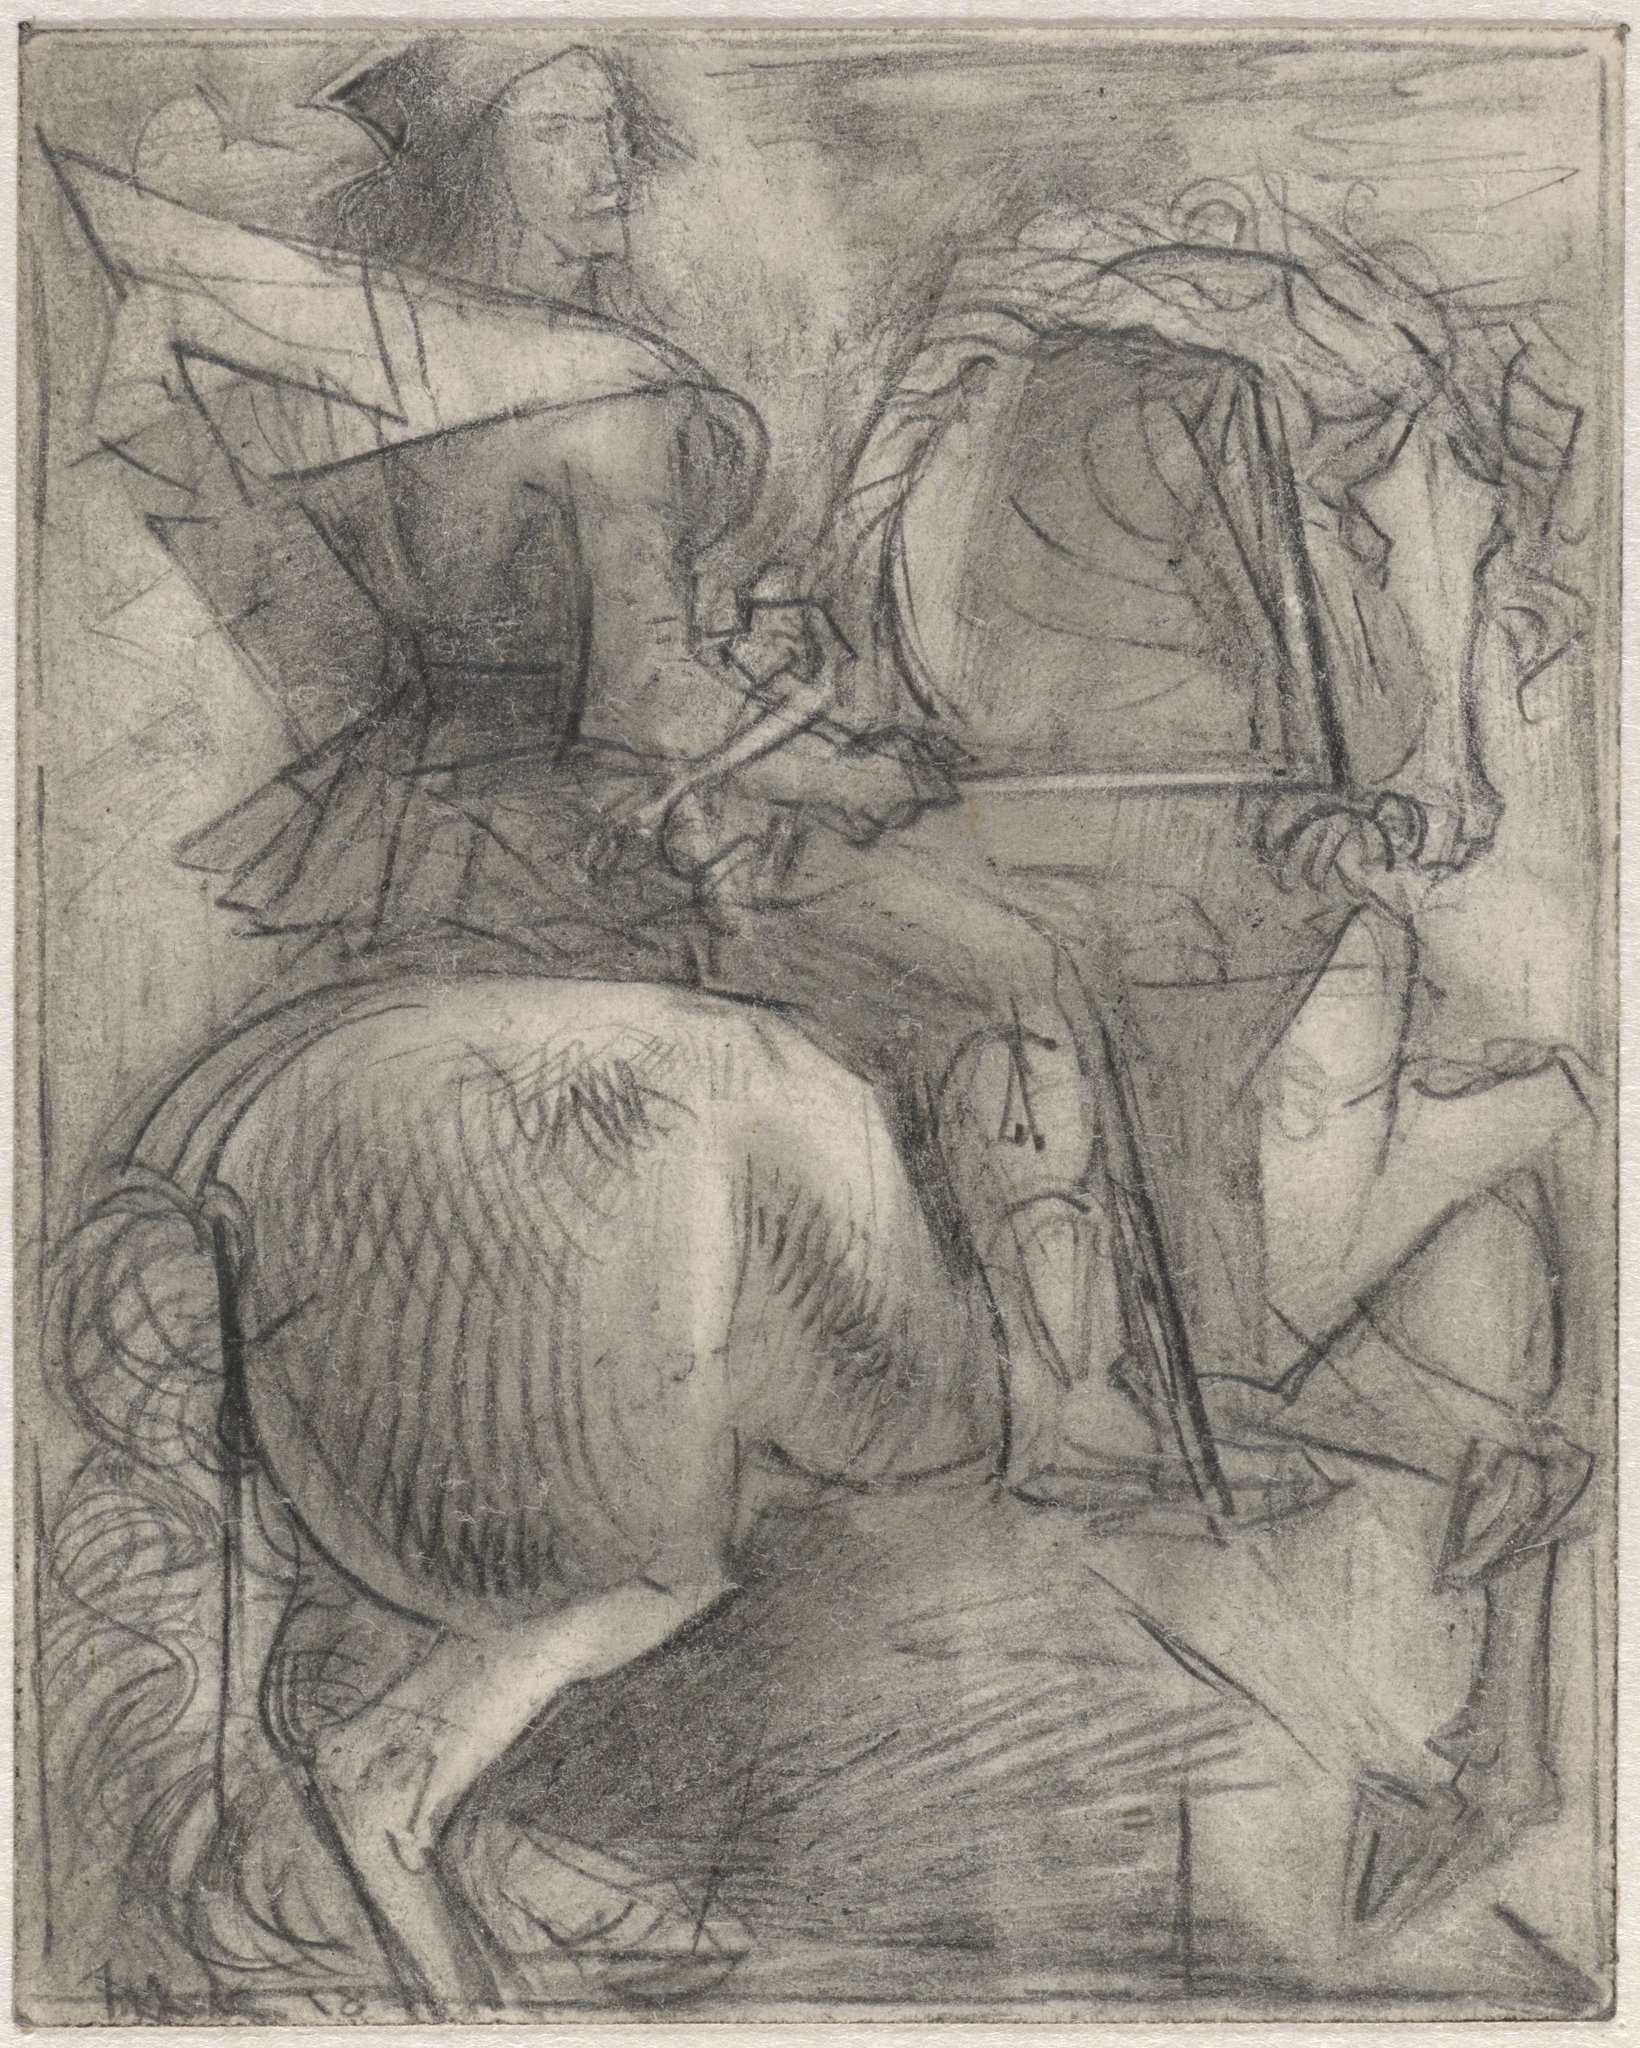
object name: drawing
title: Man op een steigerend paard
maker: willem van konijnenburg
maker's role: draughtsman, painter, print maker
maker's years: 1868-1943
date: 1918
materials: paper, pencil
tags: riding a horse, ass, or mule; rider, horseman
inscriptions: date